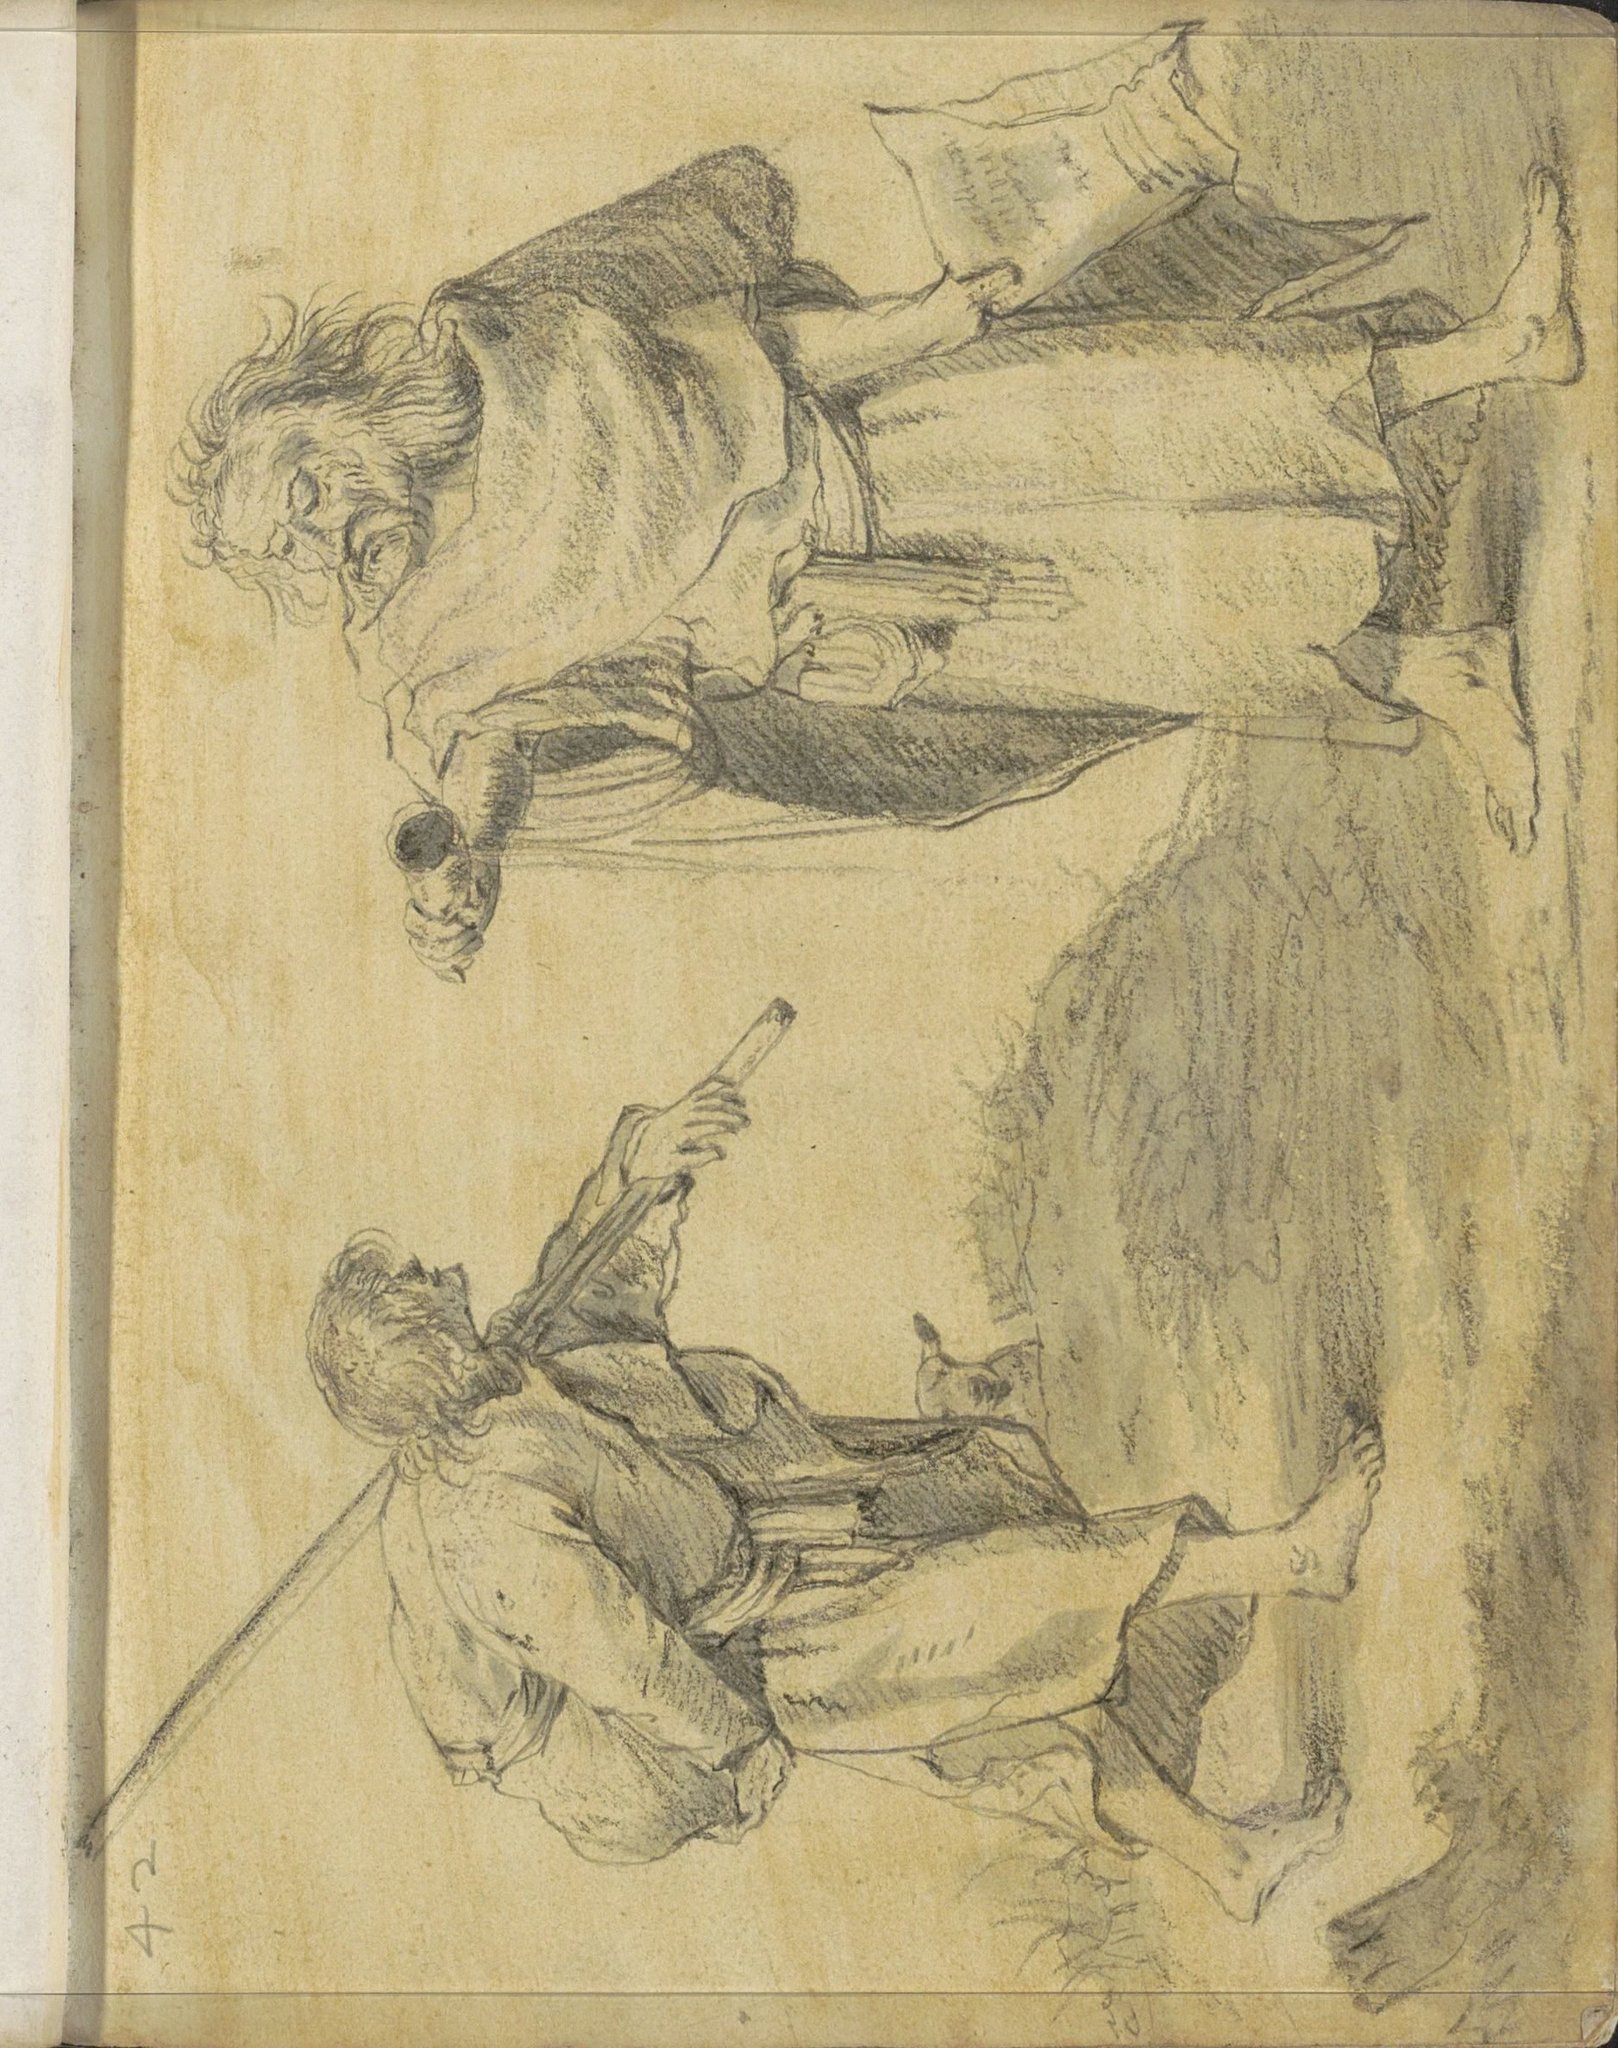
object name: sketchbook leaf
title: Lastdrager en een man met een kruik op een pad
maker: cornelis saftleven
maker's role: draughtsman, painter, print maker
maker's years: 1607-1681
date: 1666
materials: chalk, ink, paper, pencil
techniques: brush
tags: pouring, fence, wall, paling, carrying something in basket, bag, rucksack, etc.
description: Op een pad loopt een man met een stok over de schouder en een last in een zak op de rug. Op het pad staat een man die een vloeistof uit een kruik laat vloeien. In de linkerhand houdt hij een krant vast. Blad 42 recto uit een schetsboek met 49 bladen.